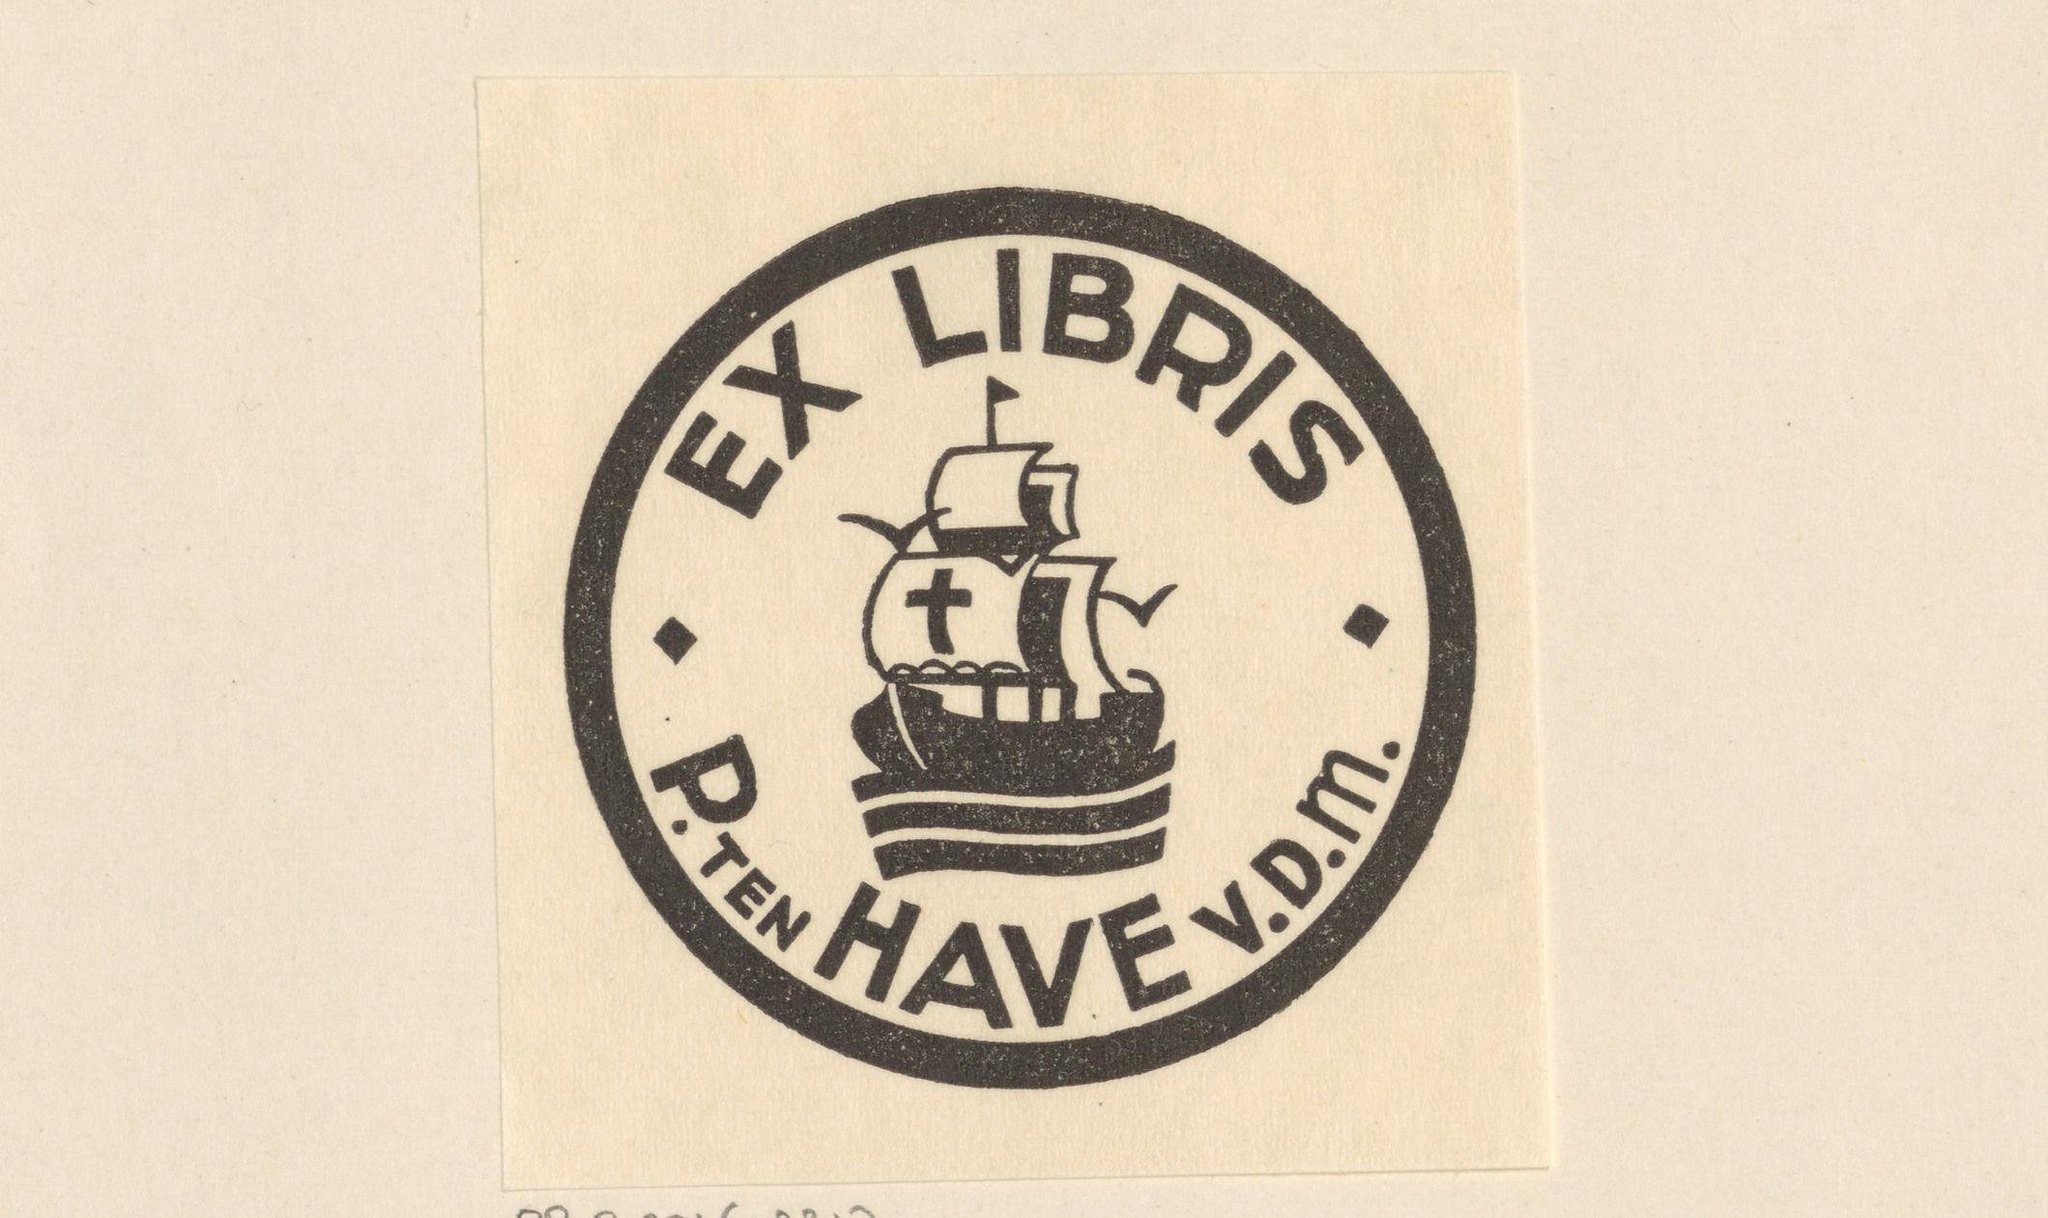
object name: bookplate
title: Ex libris van P. ten Have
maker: h. ten have-bax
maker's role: print maker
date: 1900-1999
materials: paper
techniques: printing block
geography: netherlands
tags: sailing-ship, sailing-boat, spreading the gospel; missionary work